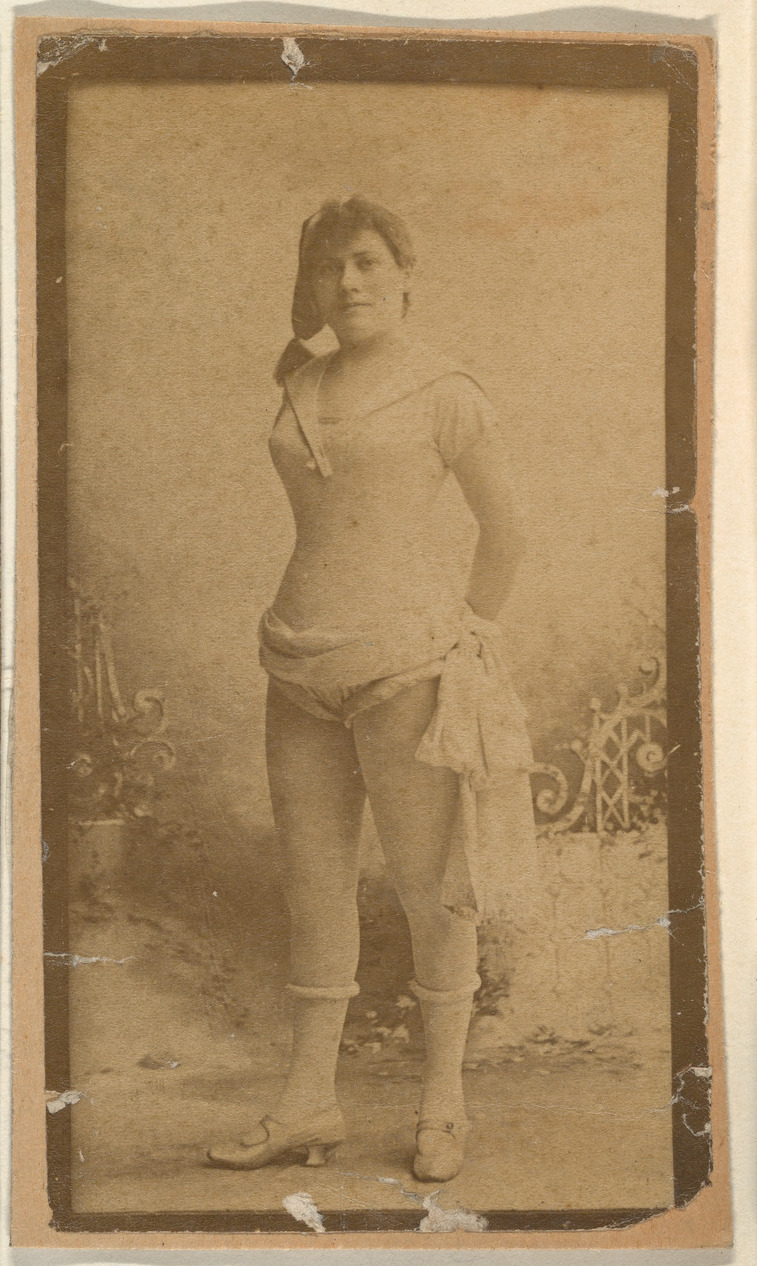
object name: photograph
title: Actress standing with hand on hip, from the Actresses series (N668)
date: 1888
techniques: albumen silver print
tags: portraits,women,actresses